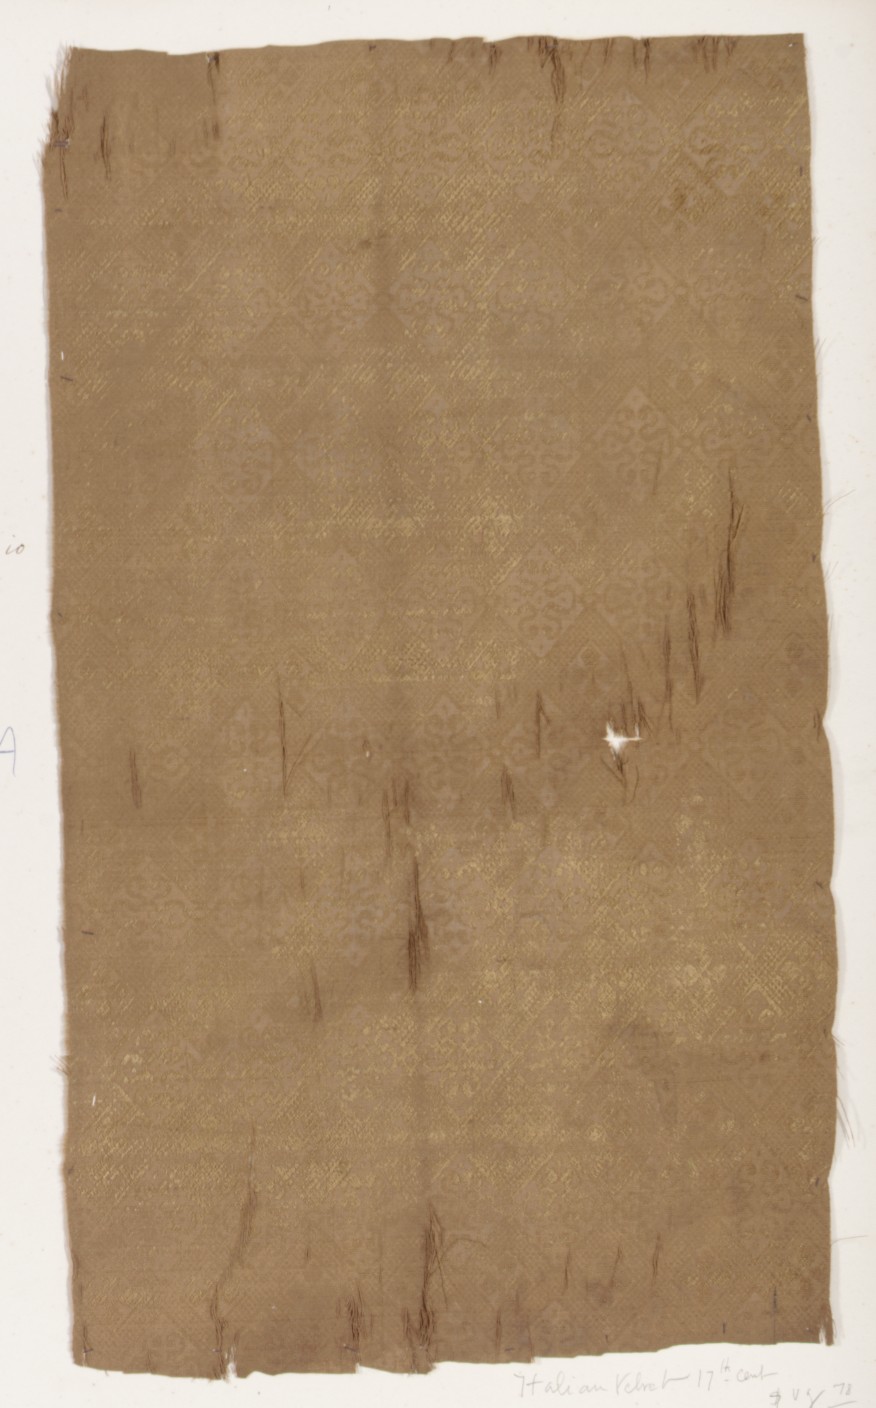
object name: fragment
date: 1601-1700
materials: silk